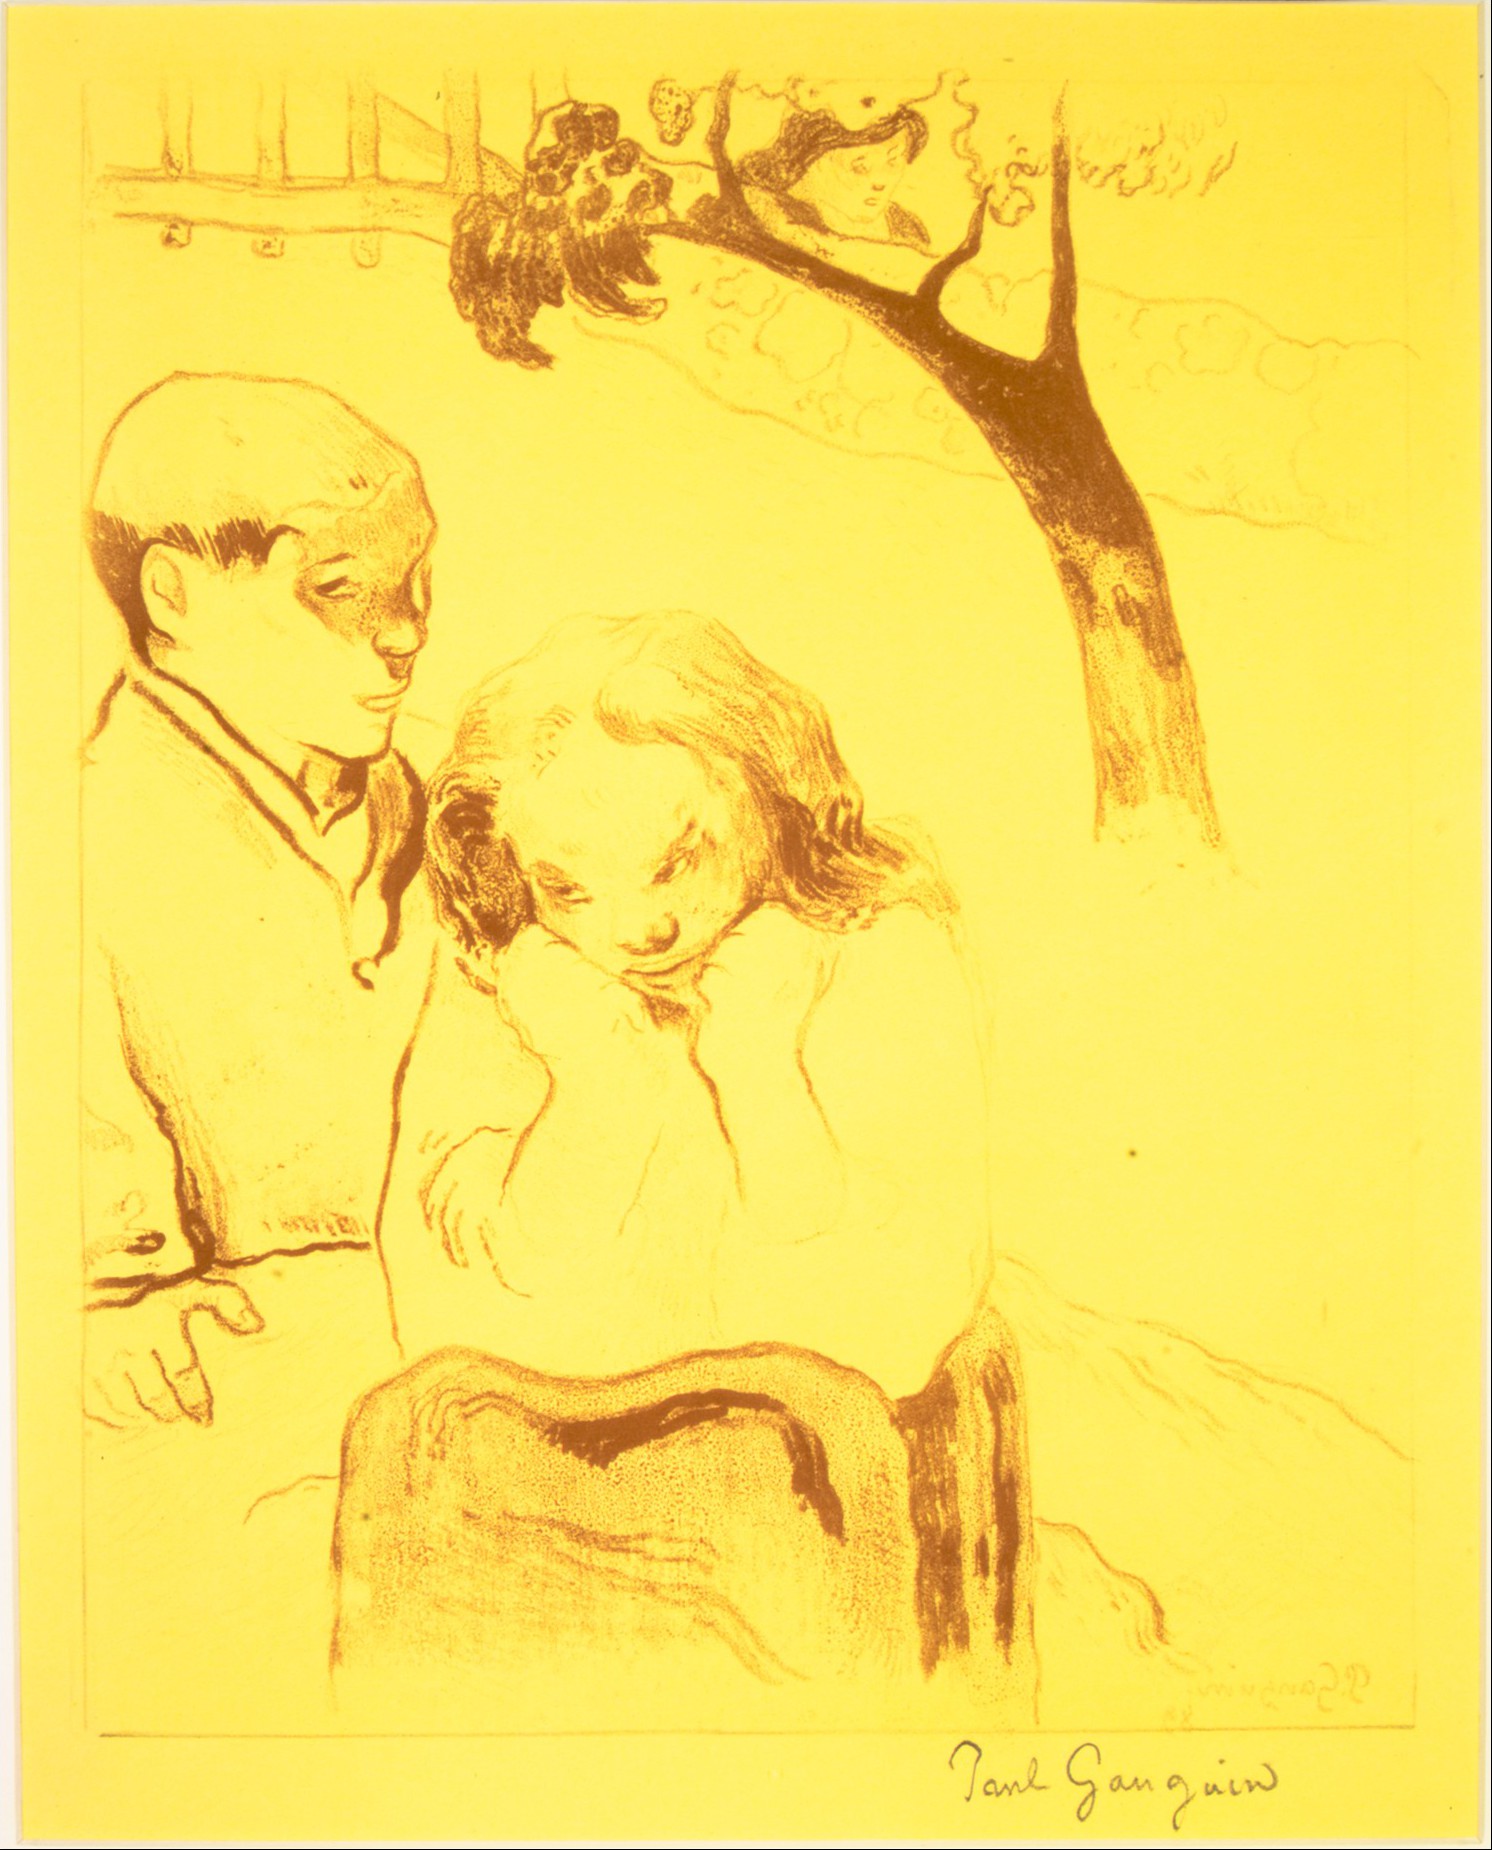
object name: print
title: Human Misery, from the "Volpini Suite: Dessins lithographiques"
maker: paul gauguin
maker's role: artist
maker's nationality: french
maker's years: 1848-1903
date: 1889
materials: ink, paper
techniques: printing, lithography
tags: contemplation,men,women